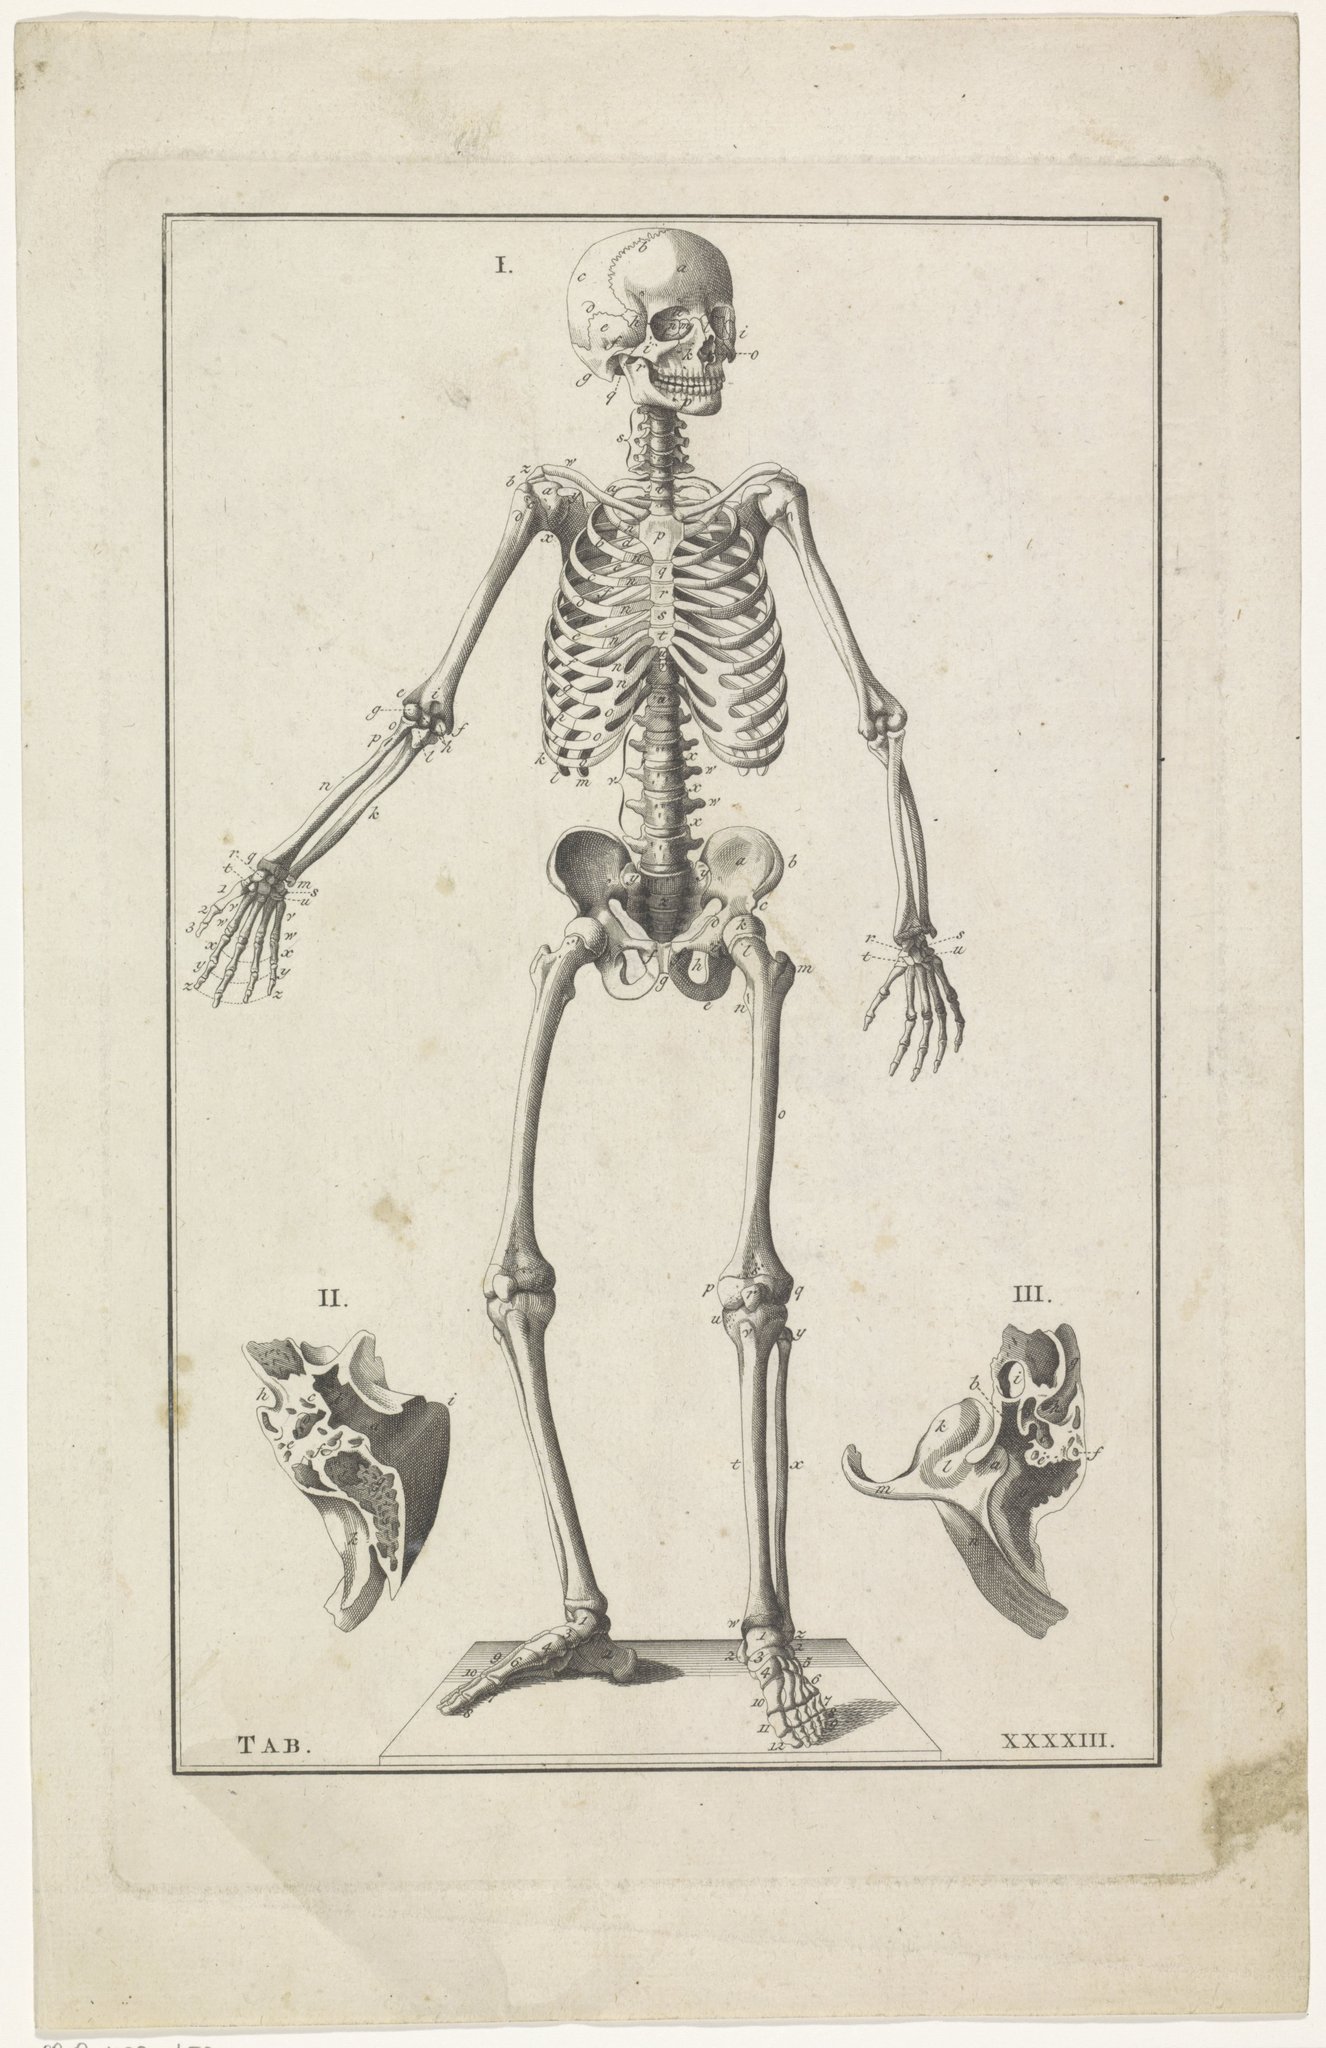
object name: print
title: Skelet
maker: Anonymous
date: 1650-1750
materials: paper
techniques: etching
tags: (human) skeleton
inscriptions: collector's mark: Lugt 2233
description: Anatomische voorstelling van een menselijk skelet. De verschillende onderdelen genummerd of geletterd. Linksonder en rechtsonder details. De voorstelling is genummerd: Tab. XXXXIII.